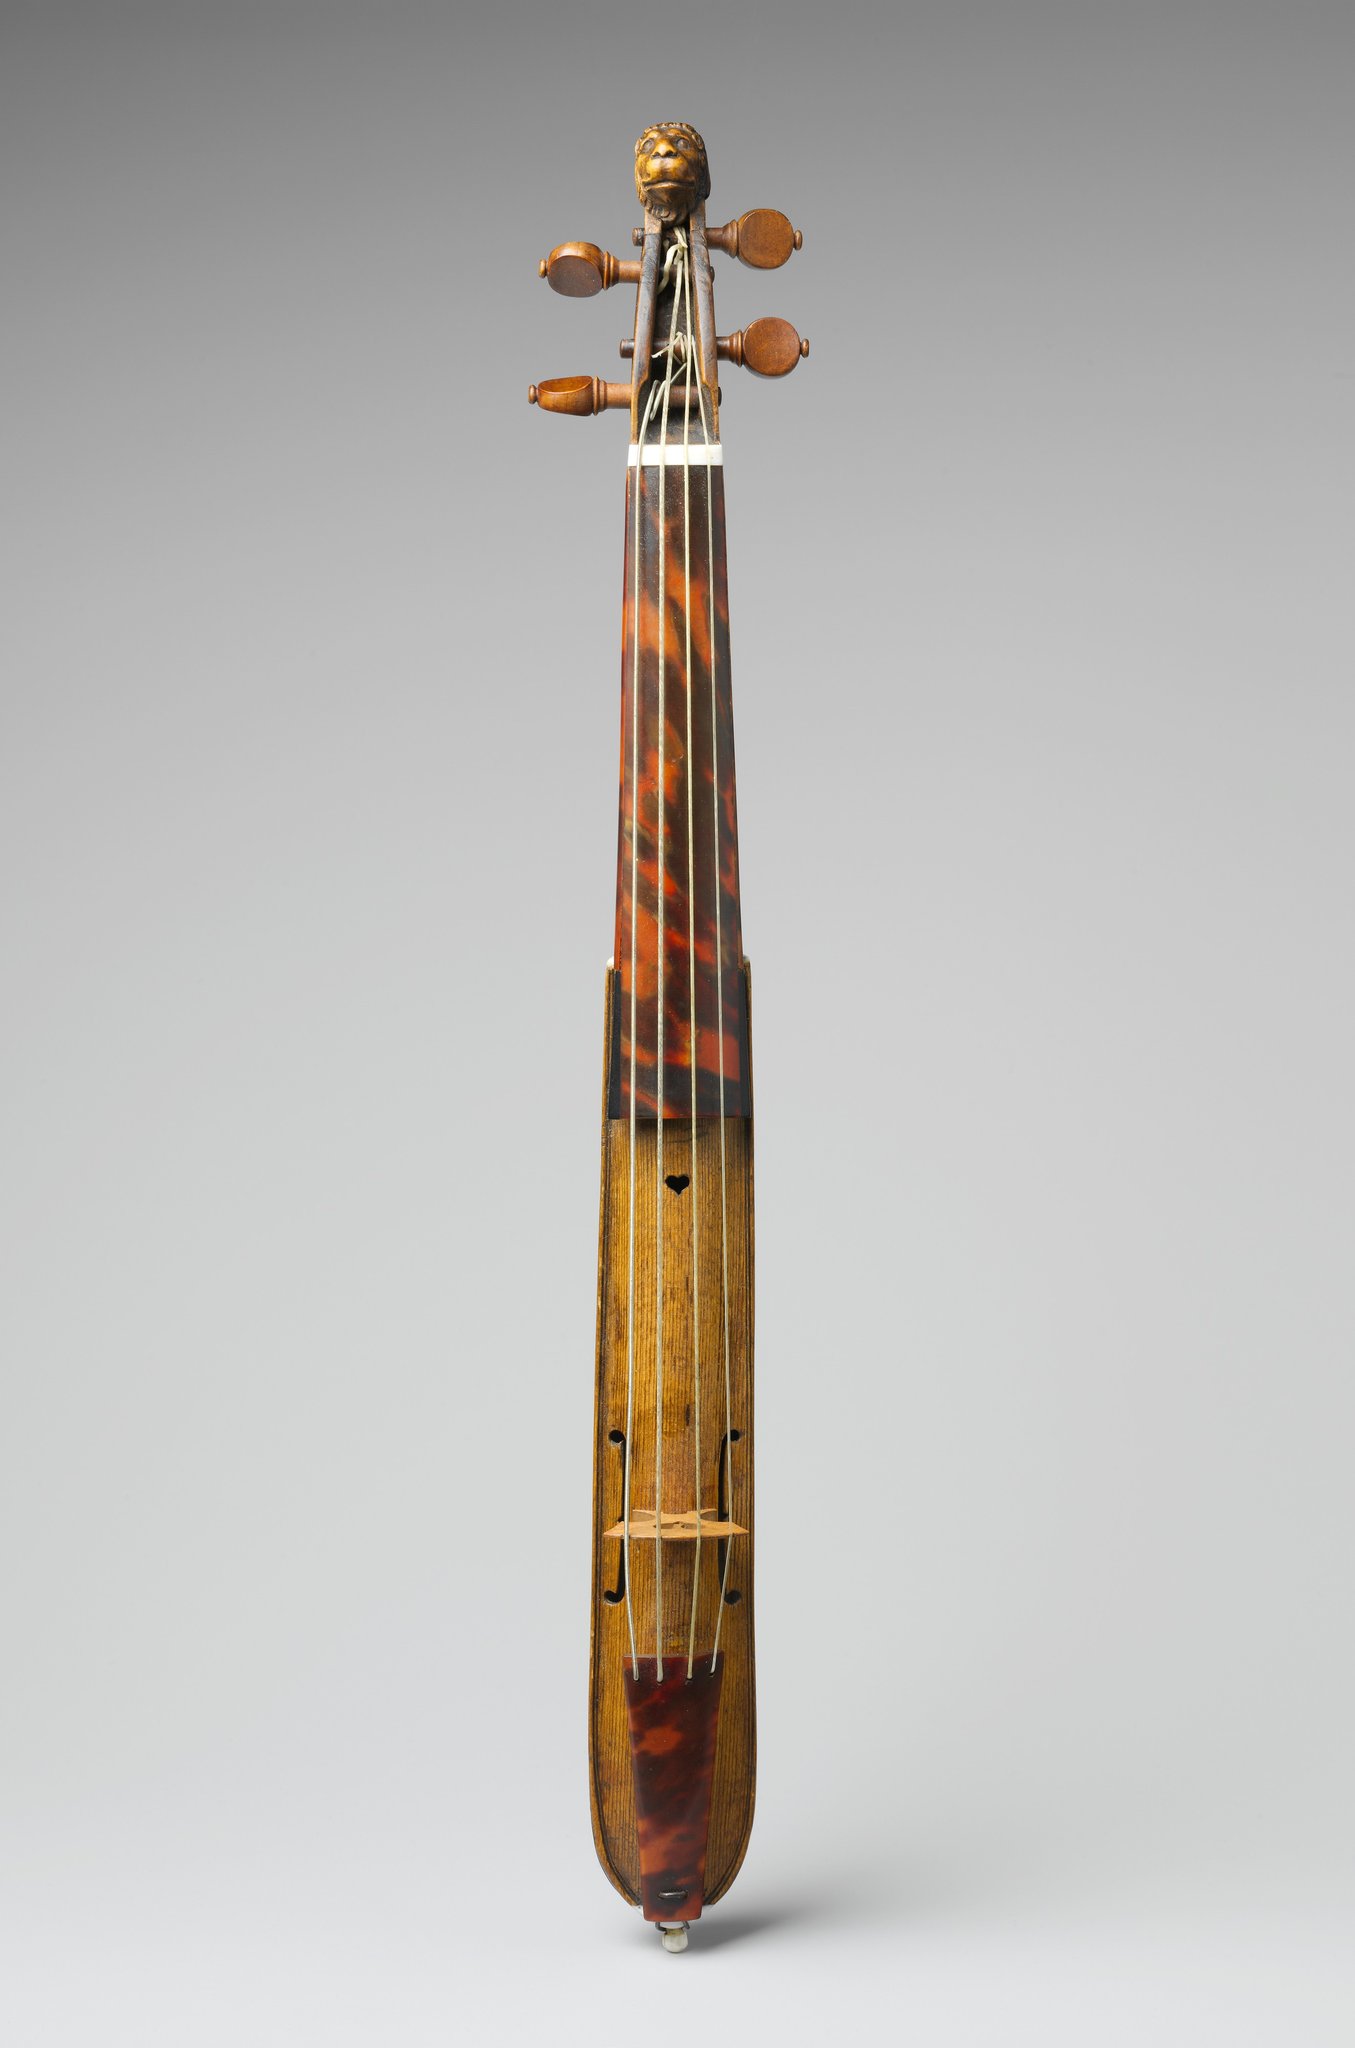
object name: pochette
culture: german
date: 1601-1700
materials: silver, shell, wood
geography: germany